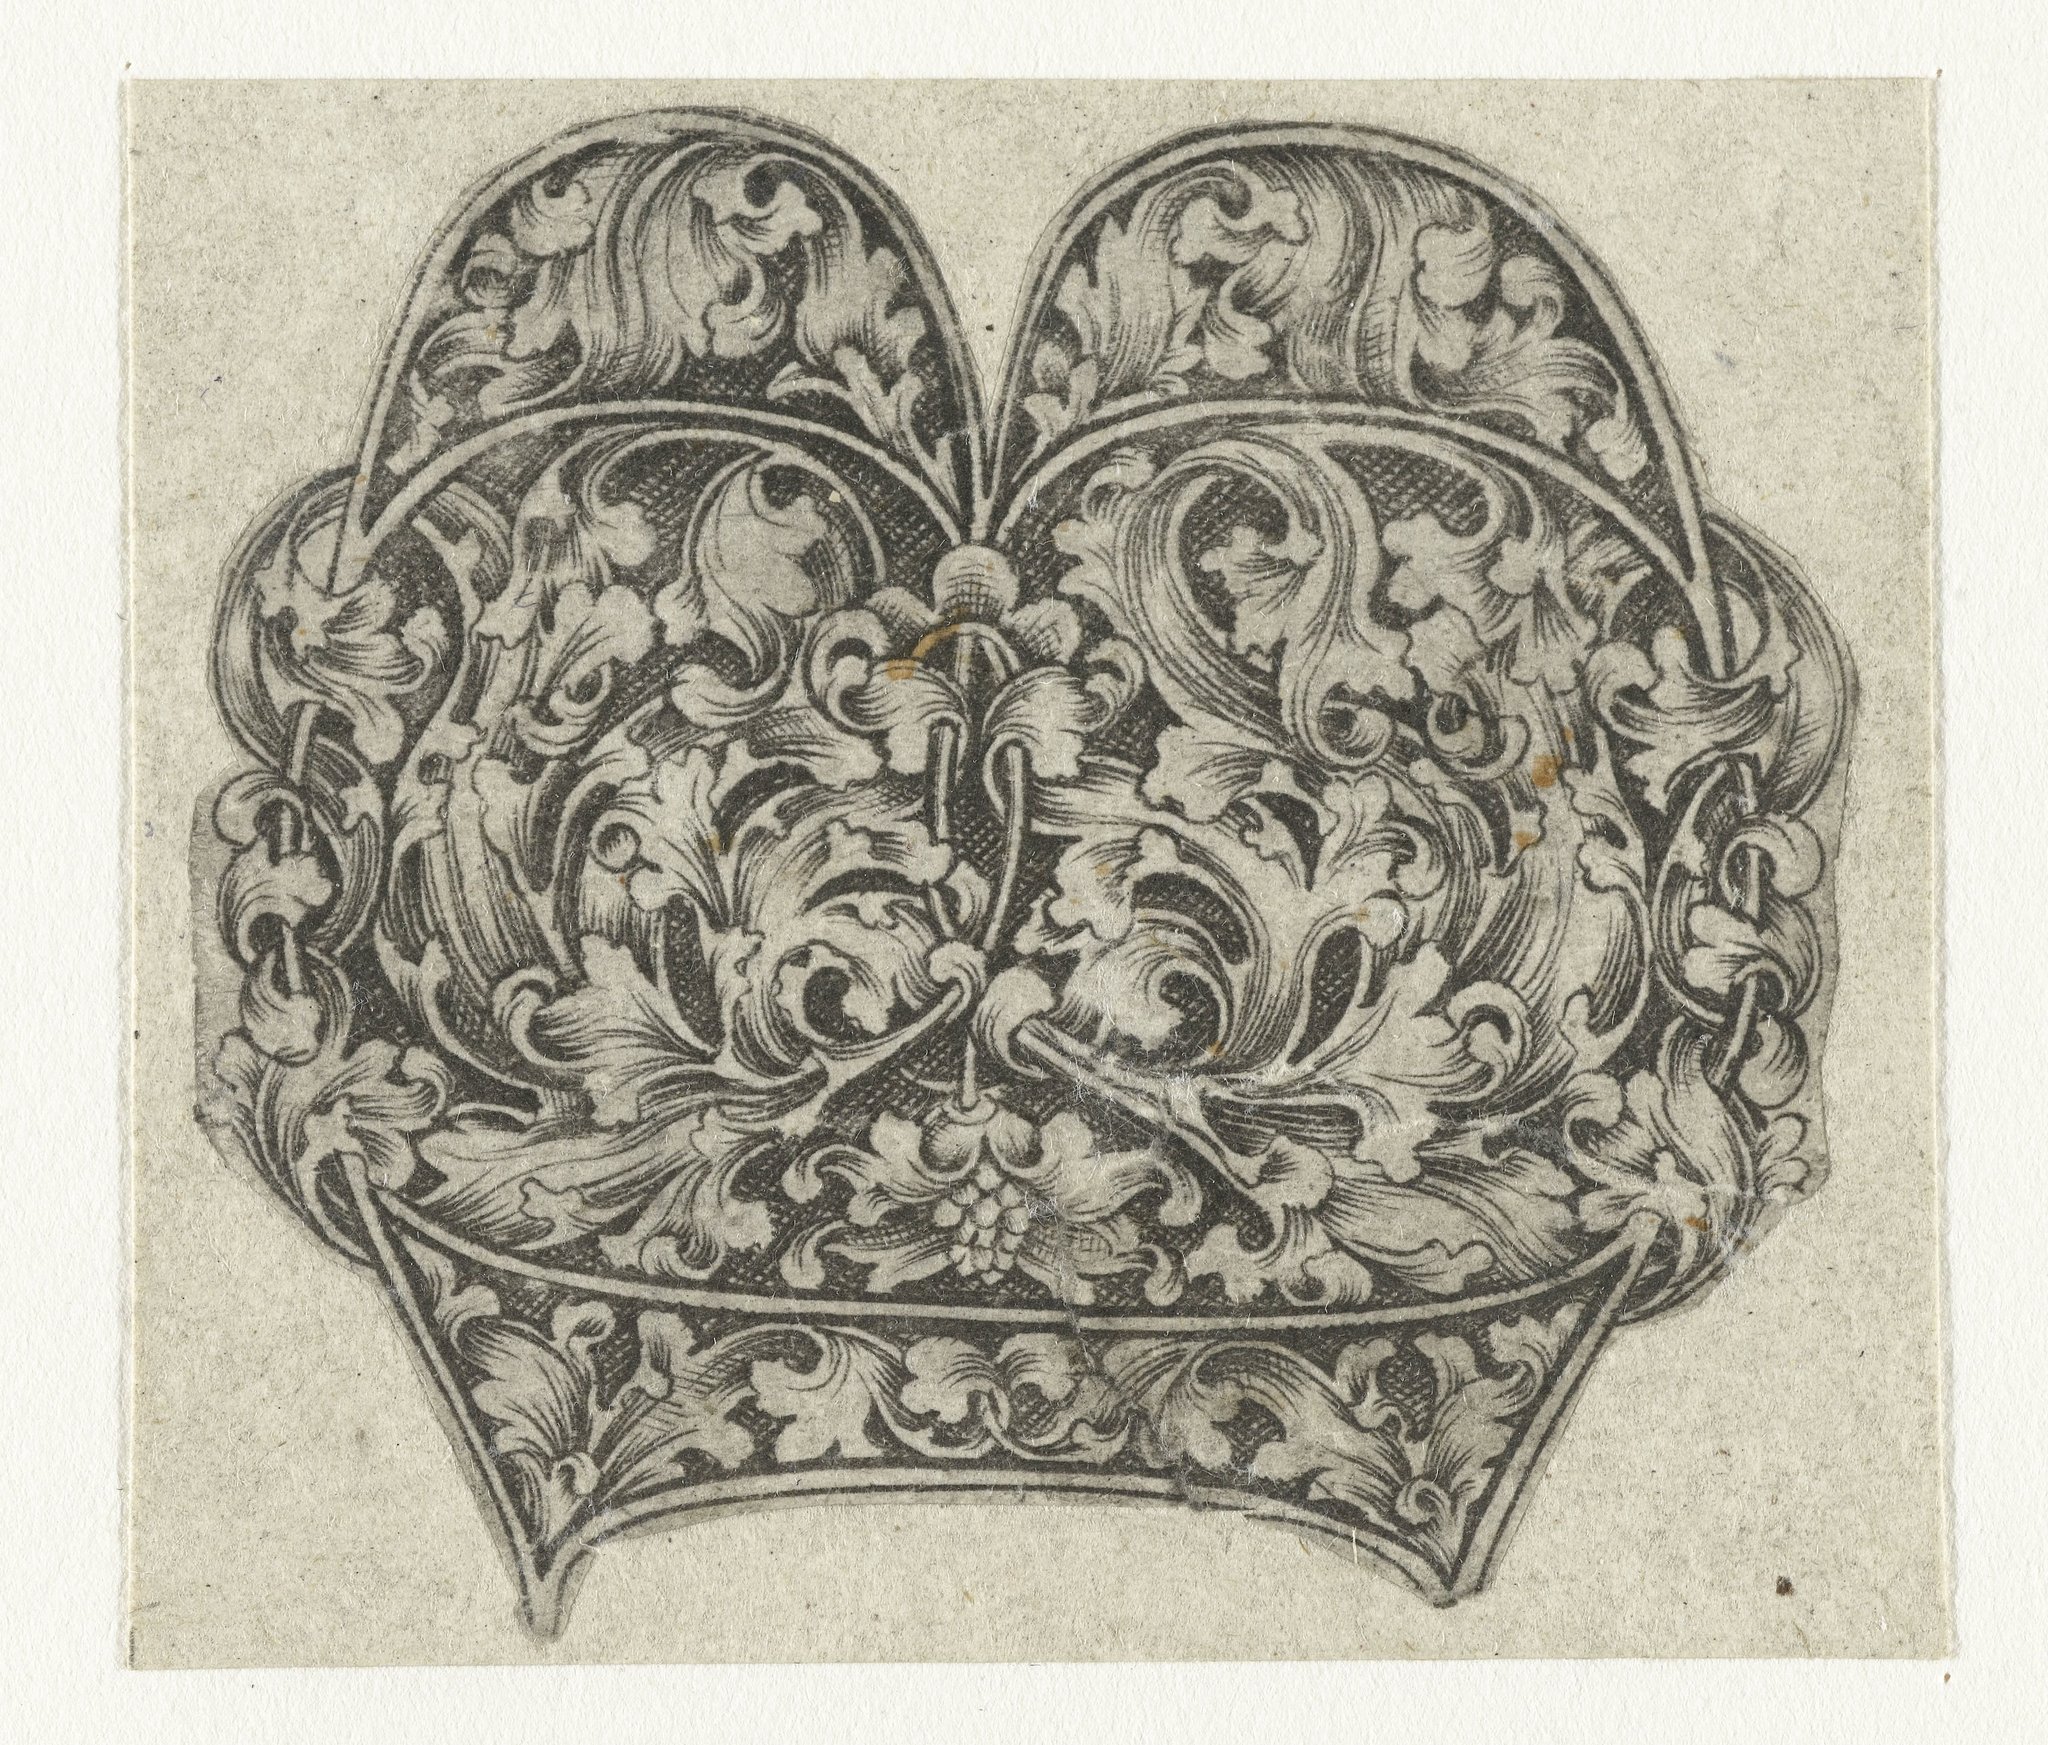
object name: print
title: Alfabet in kapitalen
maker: israhel van meckenem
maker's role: print maker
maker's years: 1440-1517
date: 1455-1503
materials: paper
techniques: engraving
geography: bocholt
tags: initial, letters, alphabet, script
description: Hoofdletter B, met bladranken versierd. Fragment van een blad waarop ook de A, de C en de D hebben gestaan. Deze prent is onderdeel van een serie van zes bladen met telkens vier kapitalen.